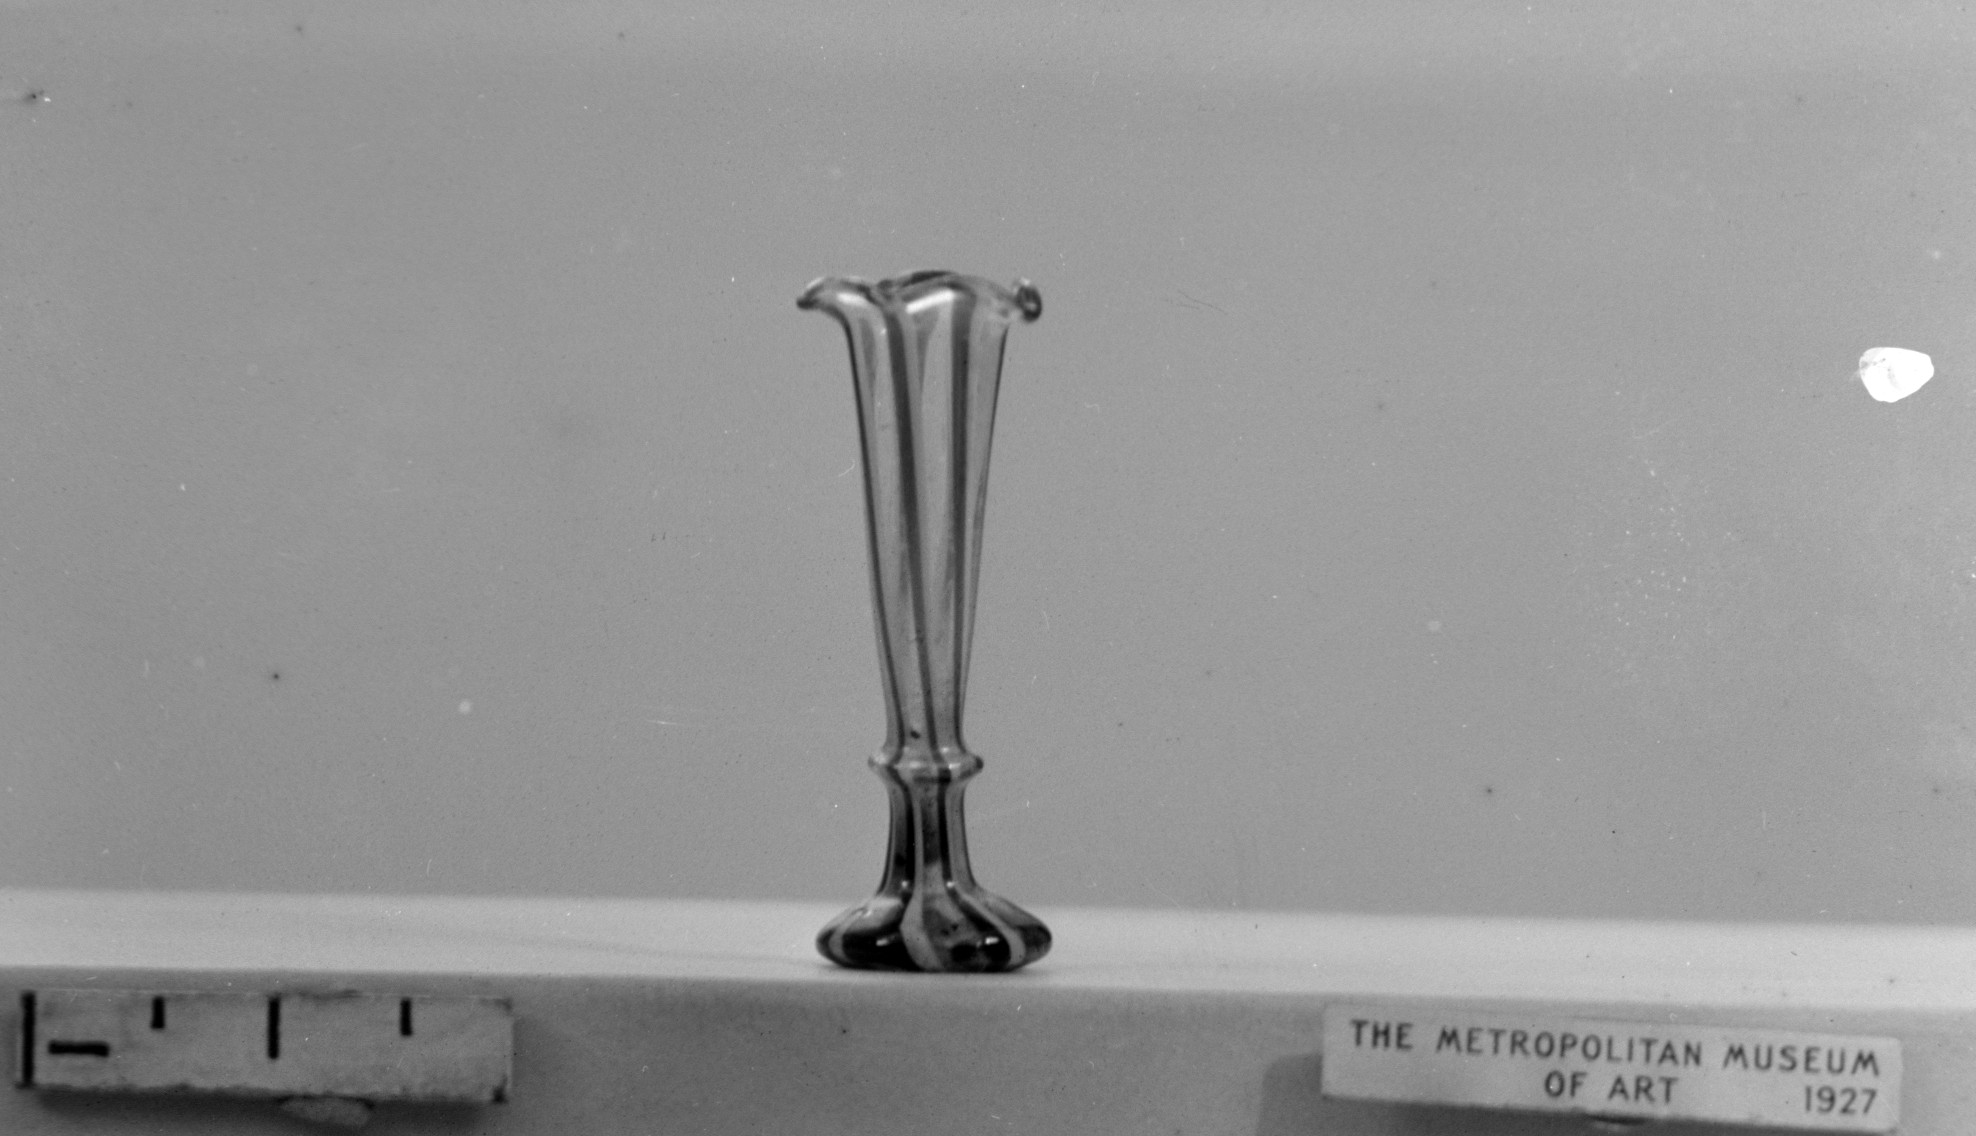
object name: vase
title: Miniature vase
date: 1801-1833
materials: glass